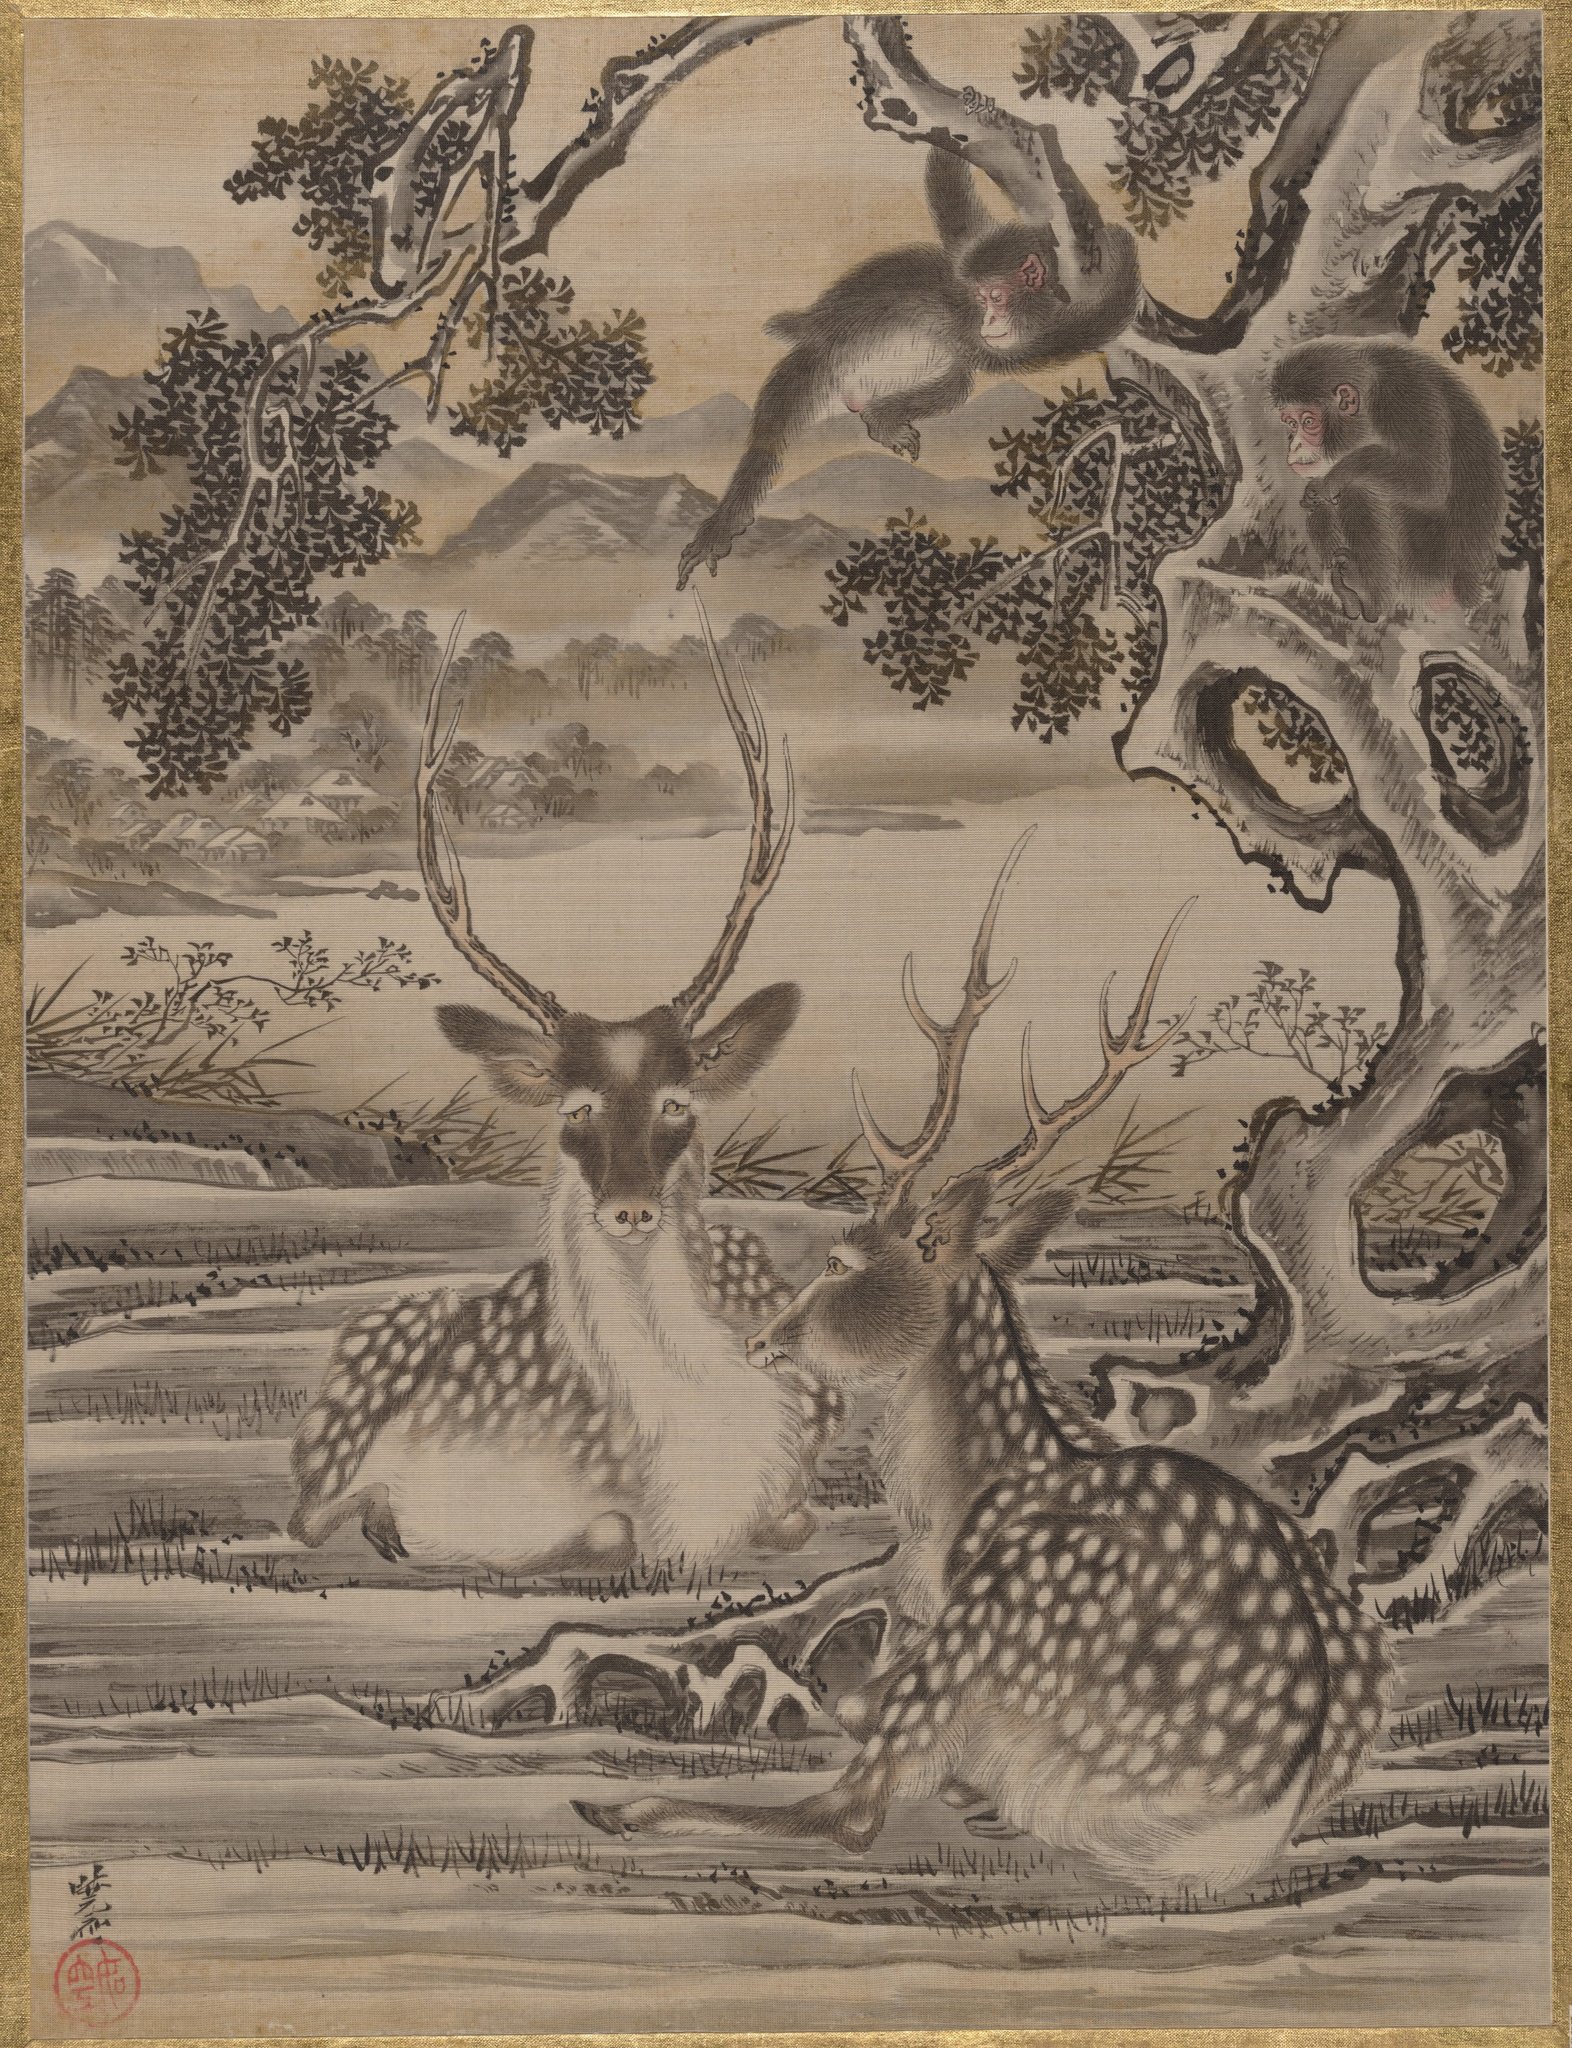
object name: album leaf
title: Deer and Monkeys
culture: japanese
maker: kawanabe kyōsai 河鍋暁斎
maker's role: artist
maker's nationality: japanese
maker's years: 1831-1889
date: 1887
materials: ink, silk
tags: deer,monkeys